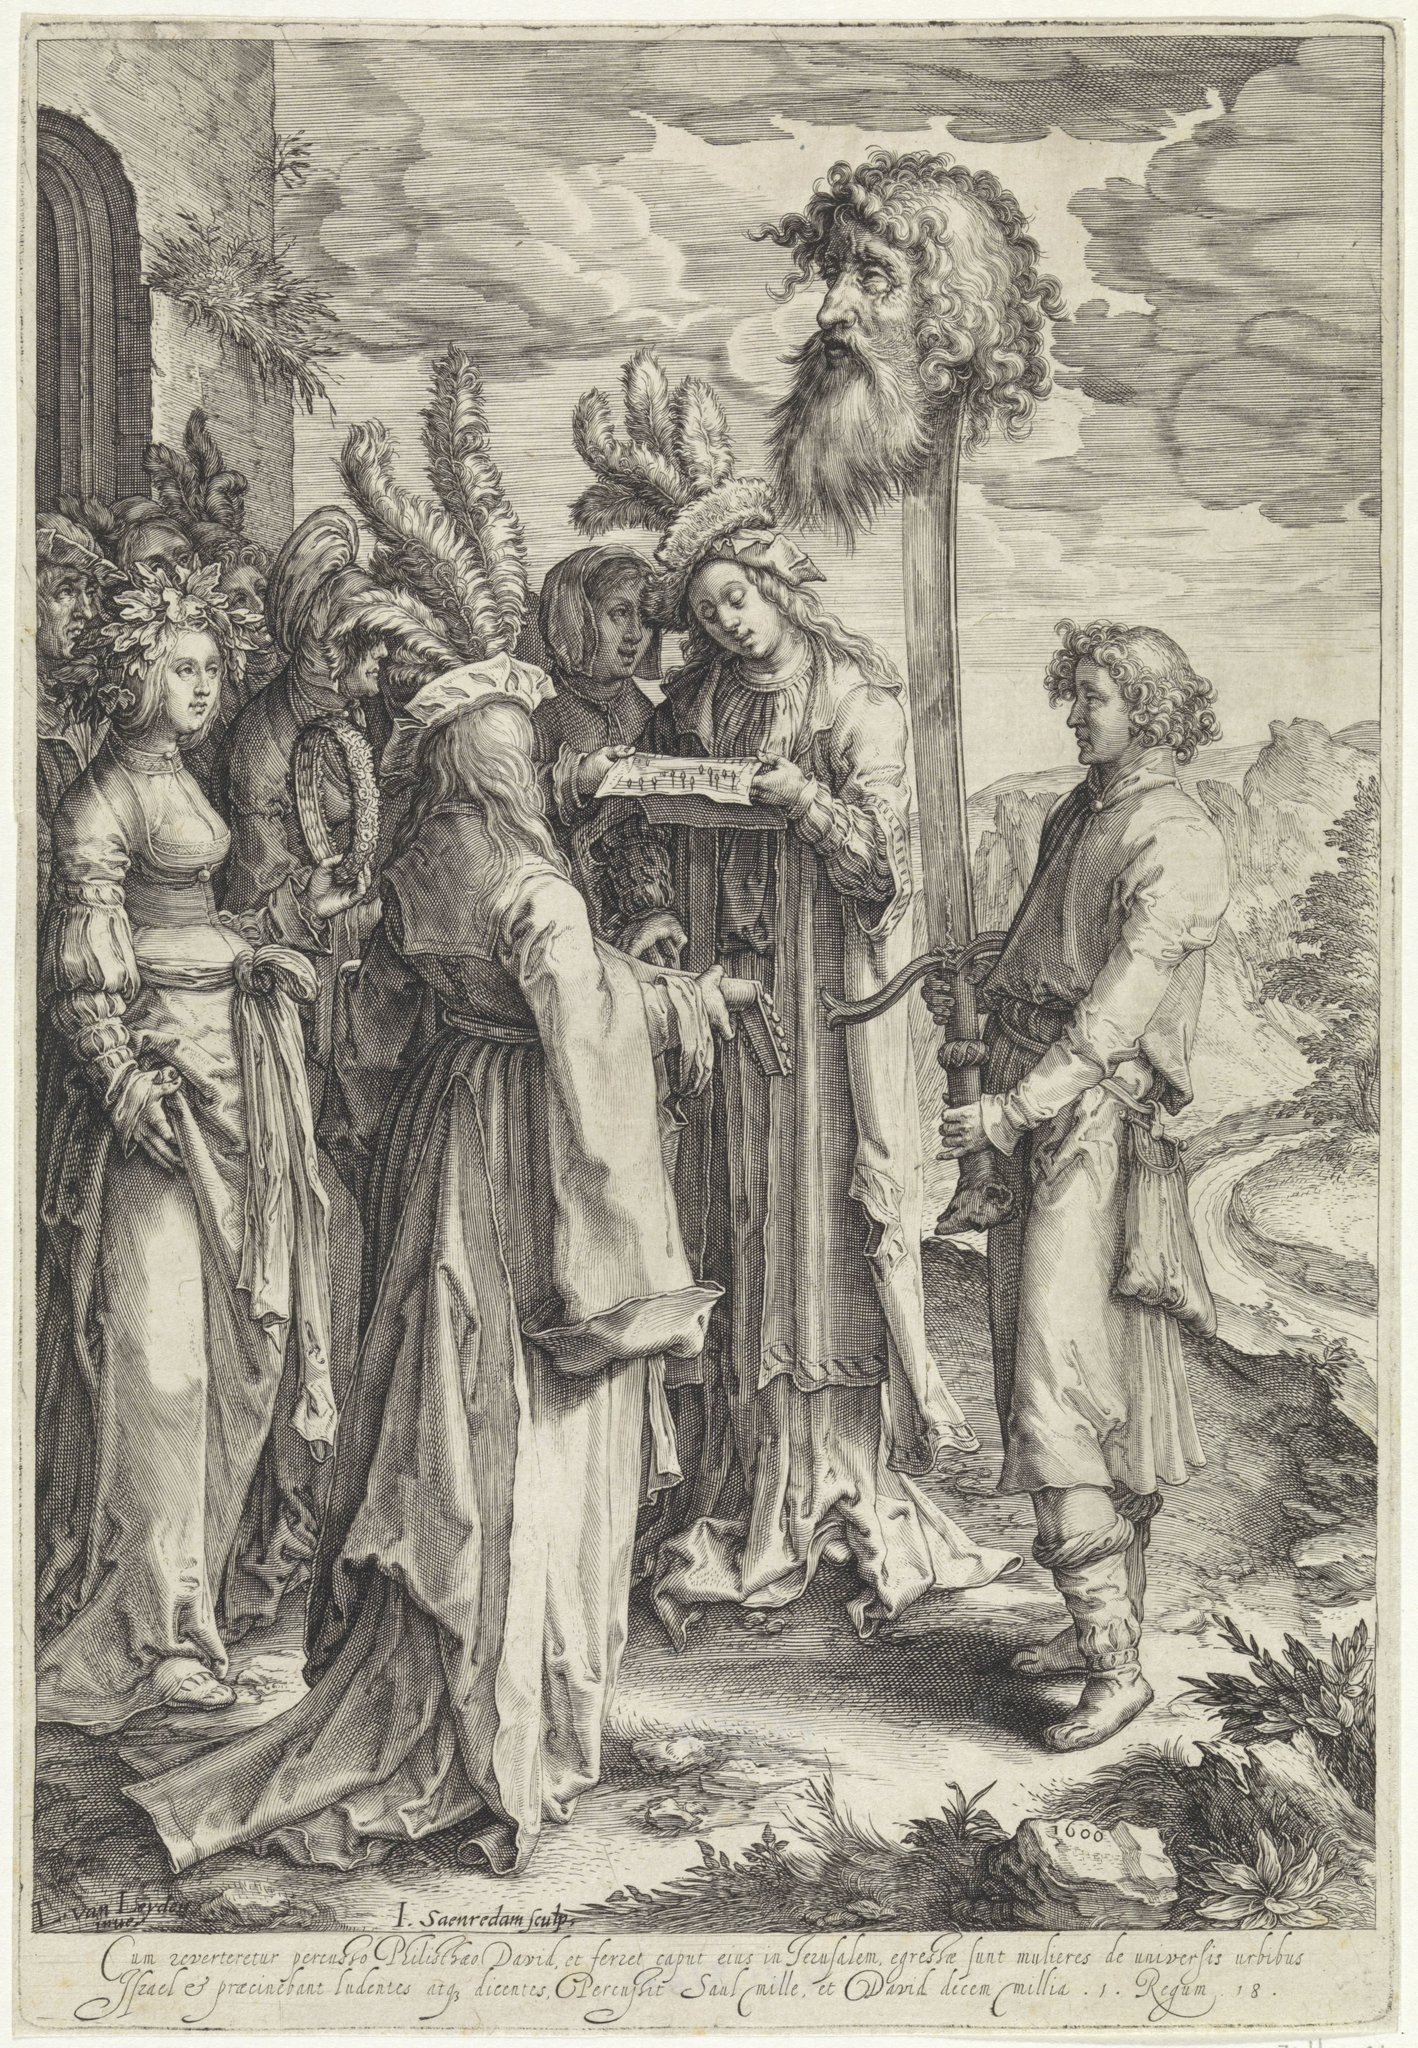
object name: print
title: Triomferende David met het hoofd van Goliat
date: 1600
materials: paper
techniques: engraving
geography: northern netherlands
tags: david's triumph: the women of israel come out to welcome david, singing, dancing, and playing tambourines and lyres; david holding the head of goliath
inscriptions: collector's mark: Lugt 2228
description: Rechts staat David met een groot zwaard. Op het zwaard is het hoofd van Goliat gespiest. Voor hem staan enkele zingende en musicerende vrouwen. Onder de voorstelling een tweeregelige, Latijnse tekst met een beschrijving van de scène uit 1 Samuel 18.